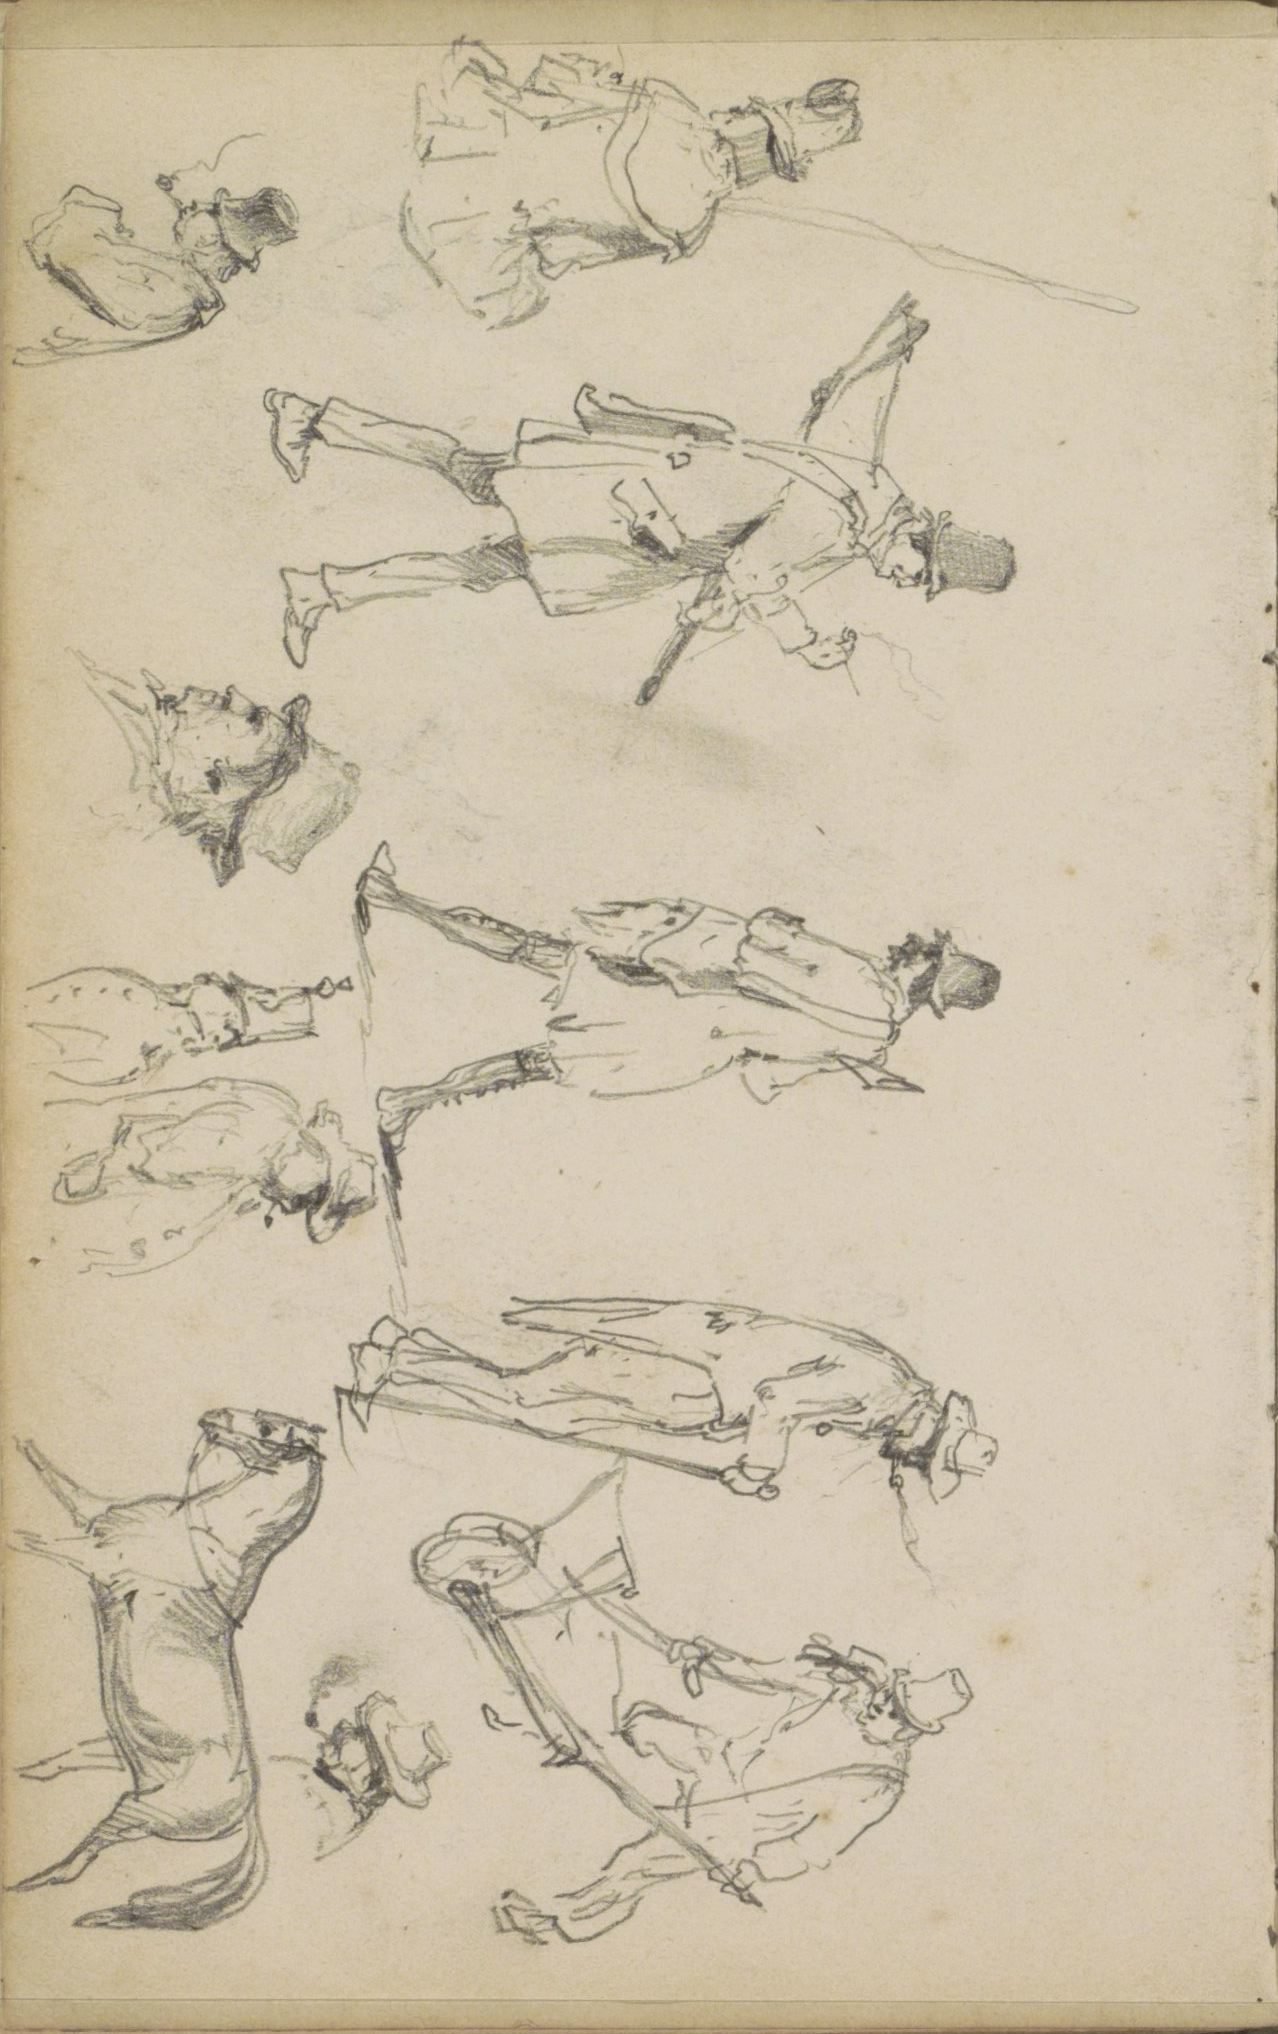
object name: sketchbook leaf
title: Jagers, pijprokende mannen en een man met een kruiwagen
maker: johannes tavenraat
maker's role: draughtsman, painter, print maker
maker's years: 1809-1881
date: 1839-1872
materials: paper, pencil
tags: hunter, pipe ~ tobacco, wheelbarrow, horse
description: Tevens studies van een paard en mannenkoppen. Blad 62 verso uit een schetsboek met 73 bladen.